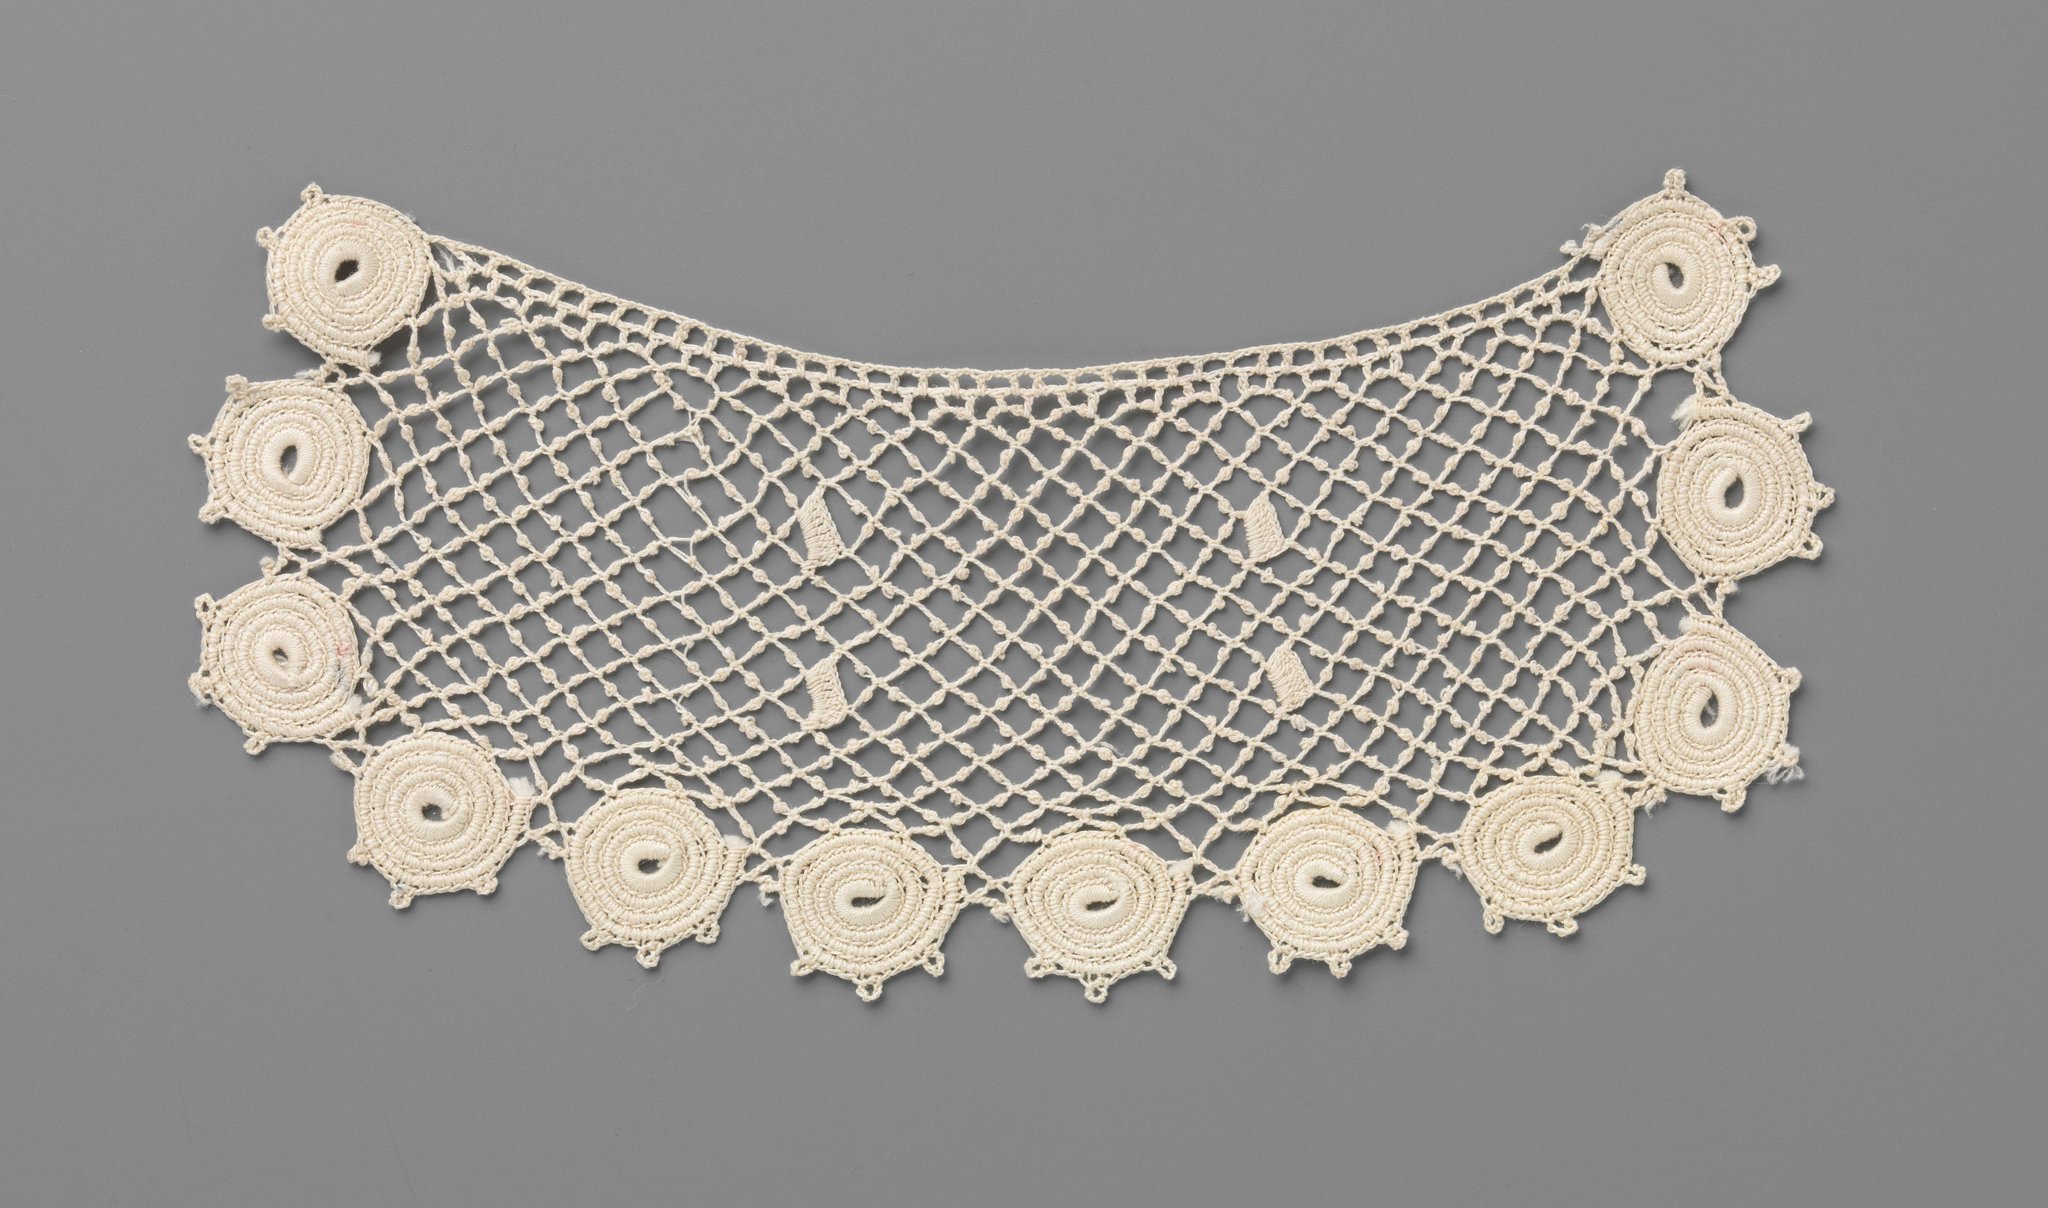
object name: cuff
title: Manchet van gehaakte kant met ronde spiraalschulpen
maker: Anonymous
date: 1930-1935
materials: cotton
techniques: crocheted lace, irish crochet lace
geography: amsterdam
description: Manchet van naturelkleurige Ierse gehaakte kant. Rechthoekig model met afgeronde hoeken. Vier moesjes, licht gebogen rechthoekjes, in twee rijen in een ruitvormige netwerk met picots. Aan drie zijden afgewerkt met een schulpenrand van aaneengeschakelde ronde spiraalschulpen, die worden gevormd door een rondgelegde en omgehaakte draadbundel. De bovenzijde is recht afgewerkt.